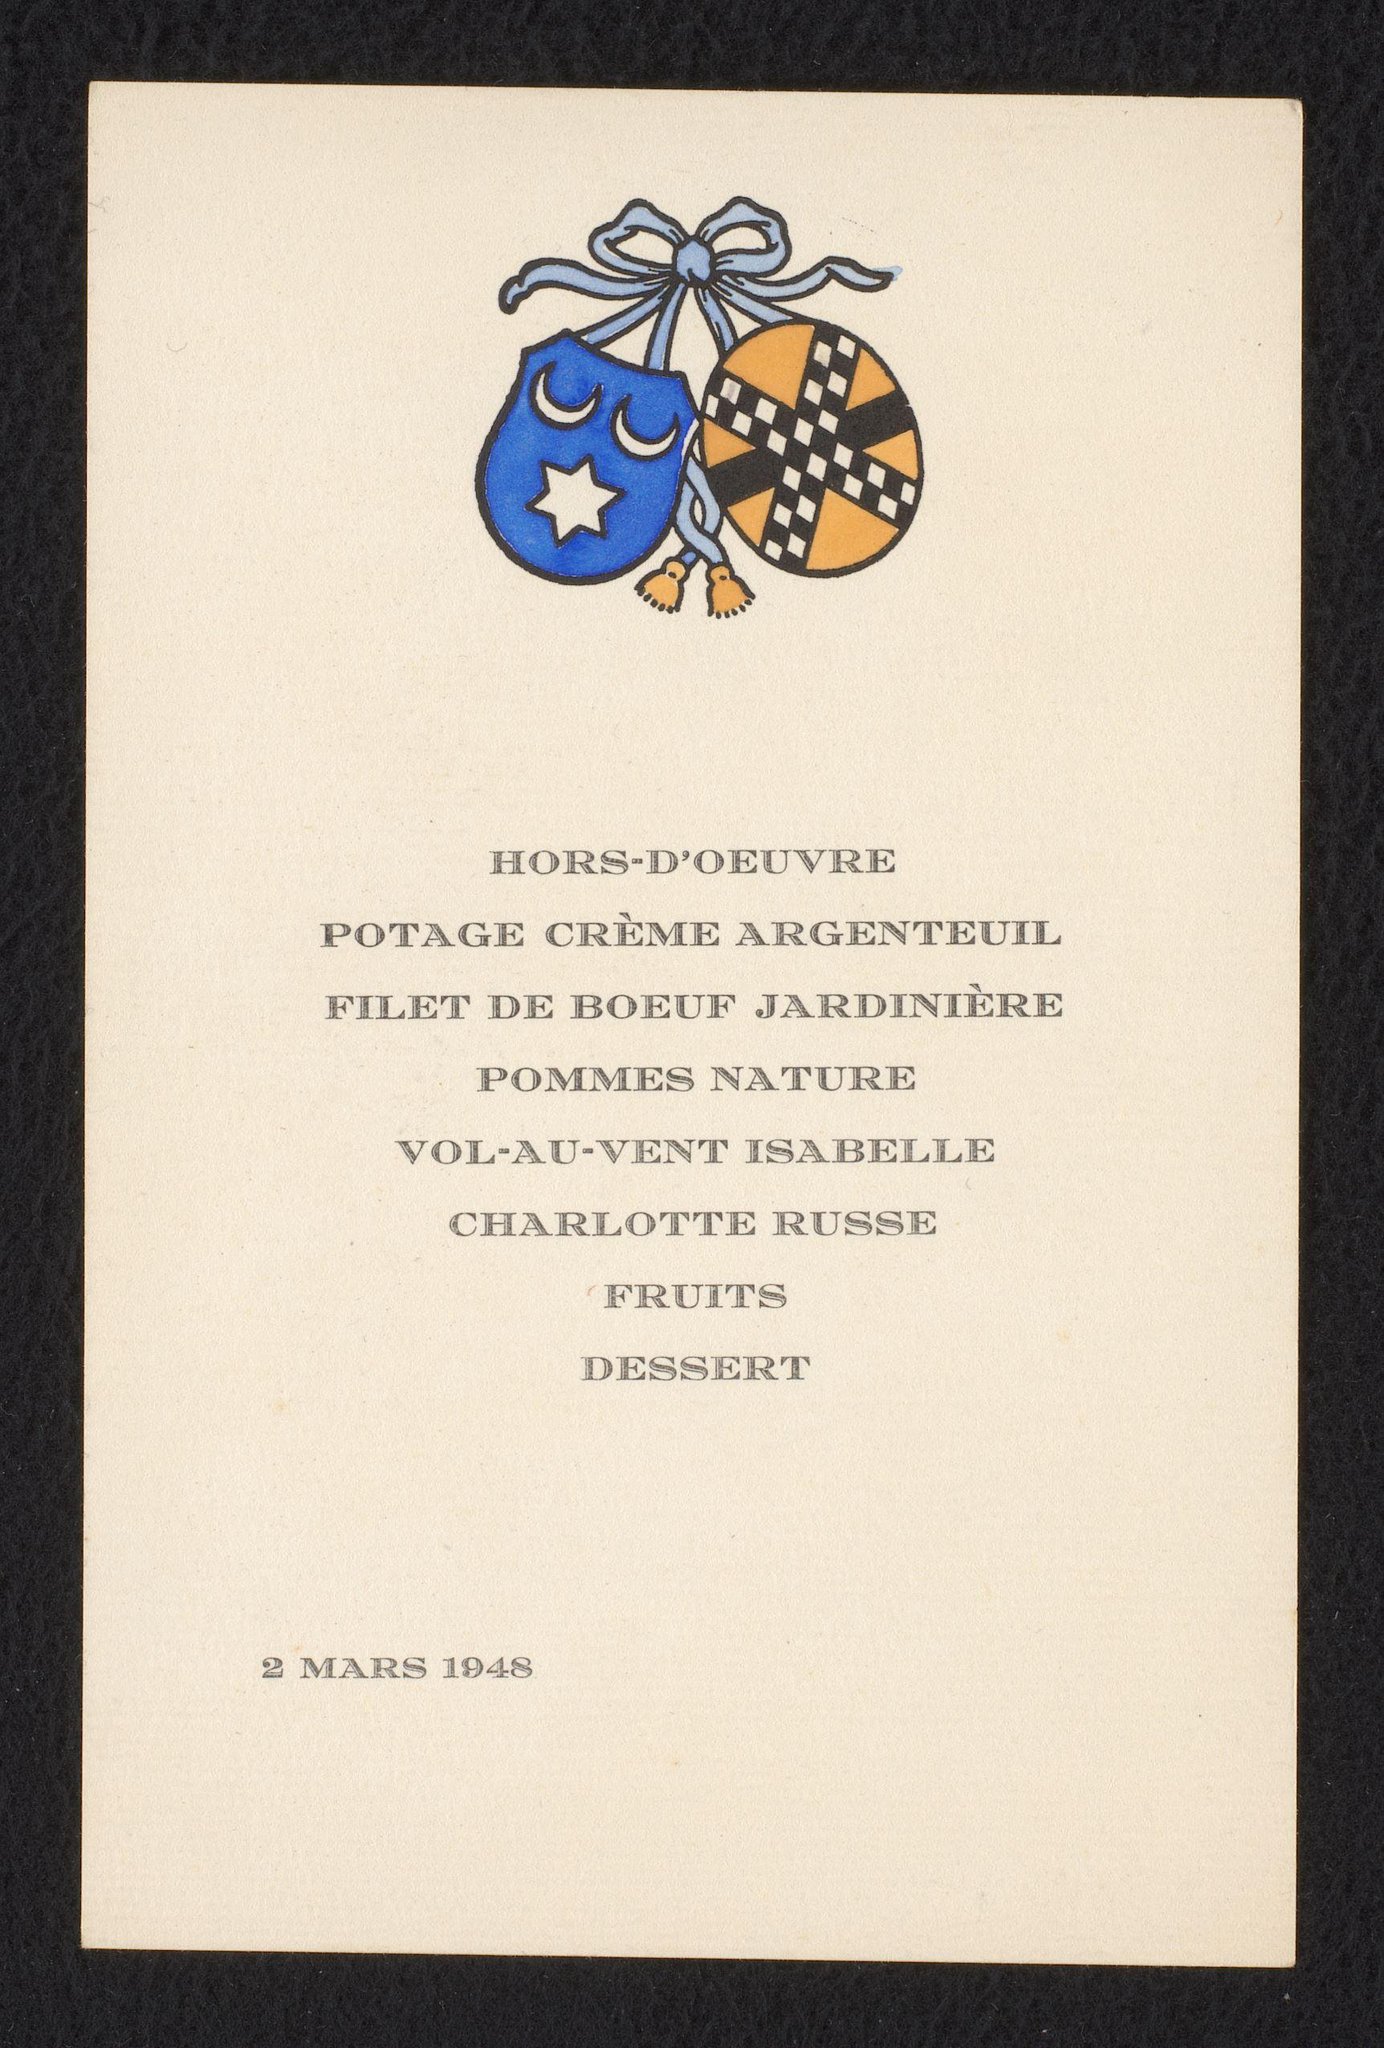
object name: menu, menukaart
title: Menukaart voor een diner op 2 maart 1948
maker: Anonymous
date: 1948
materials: paper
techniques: hand coloring, letterpress printing, printing block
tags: armorial bearing, heraldry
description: Bij gebrek aan gegevens over de vervaardiger is voor de bepaling van de rechten van dit object gebruik gemaakt van de vervaardigingsdatum.